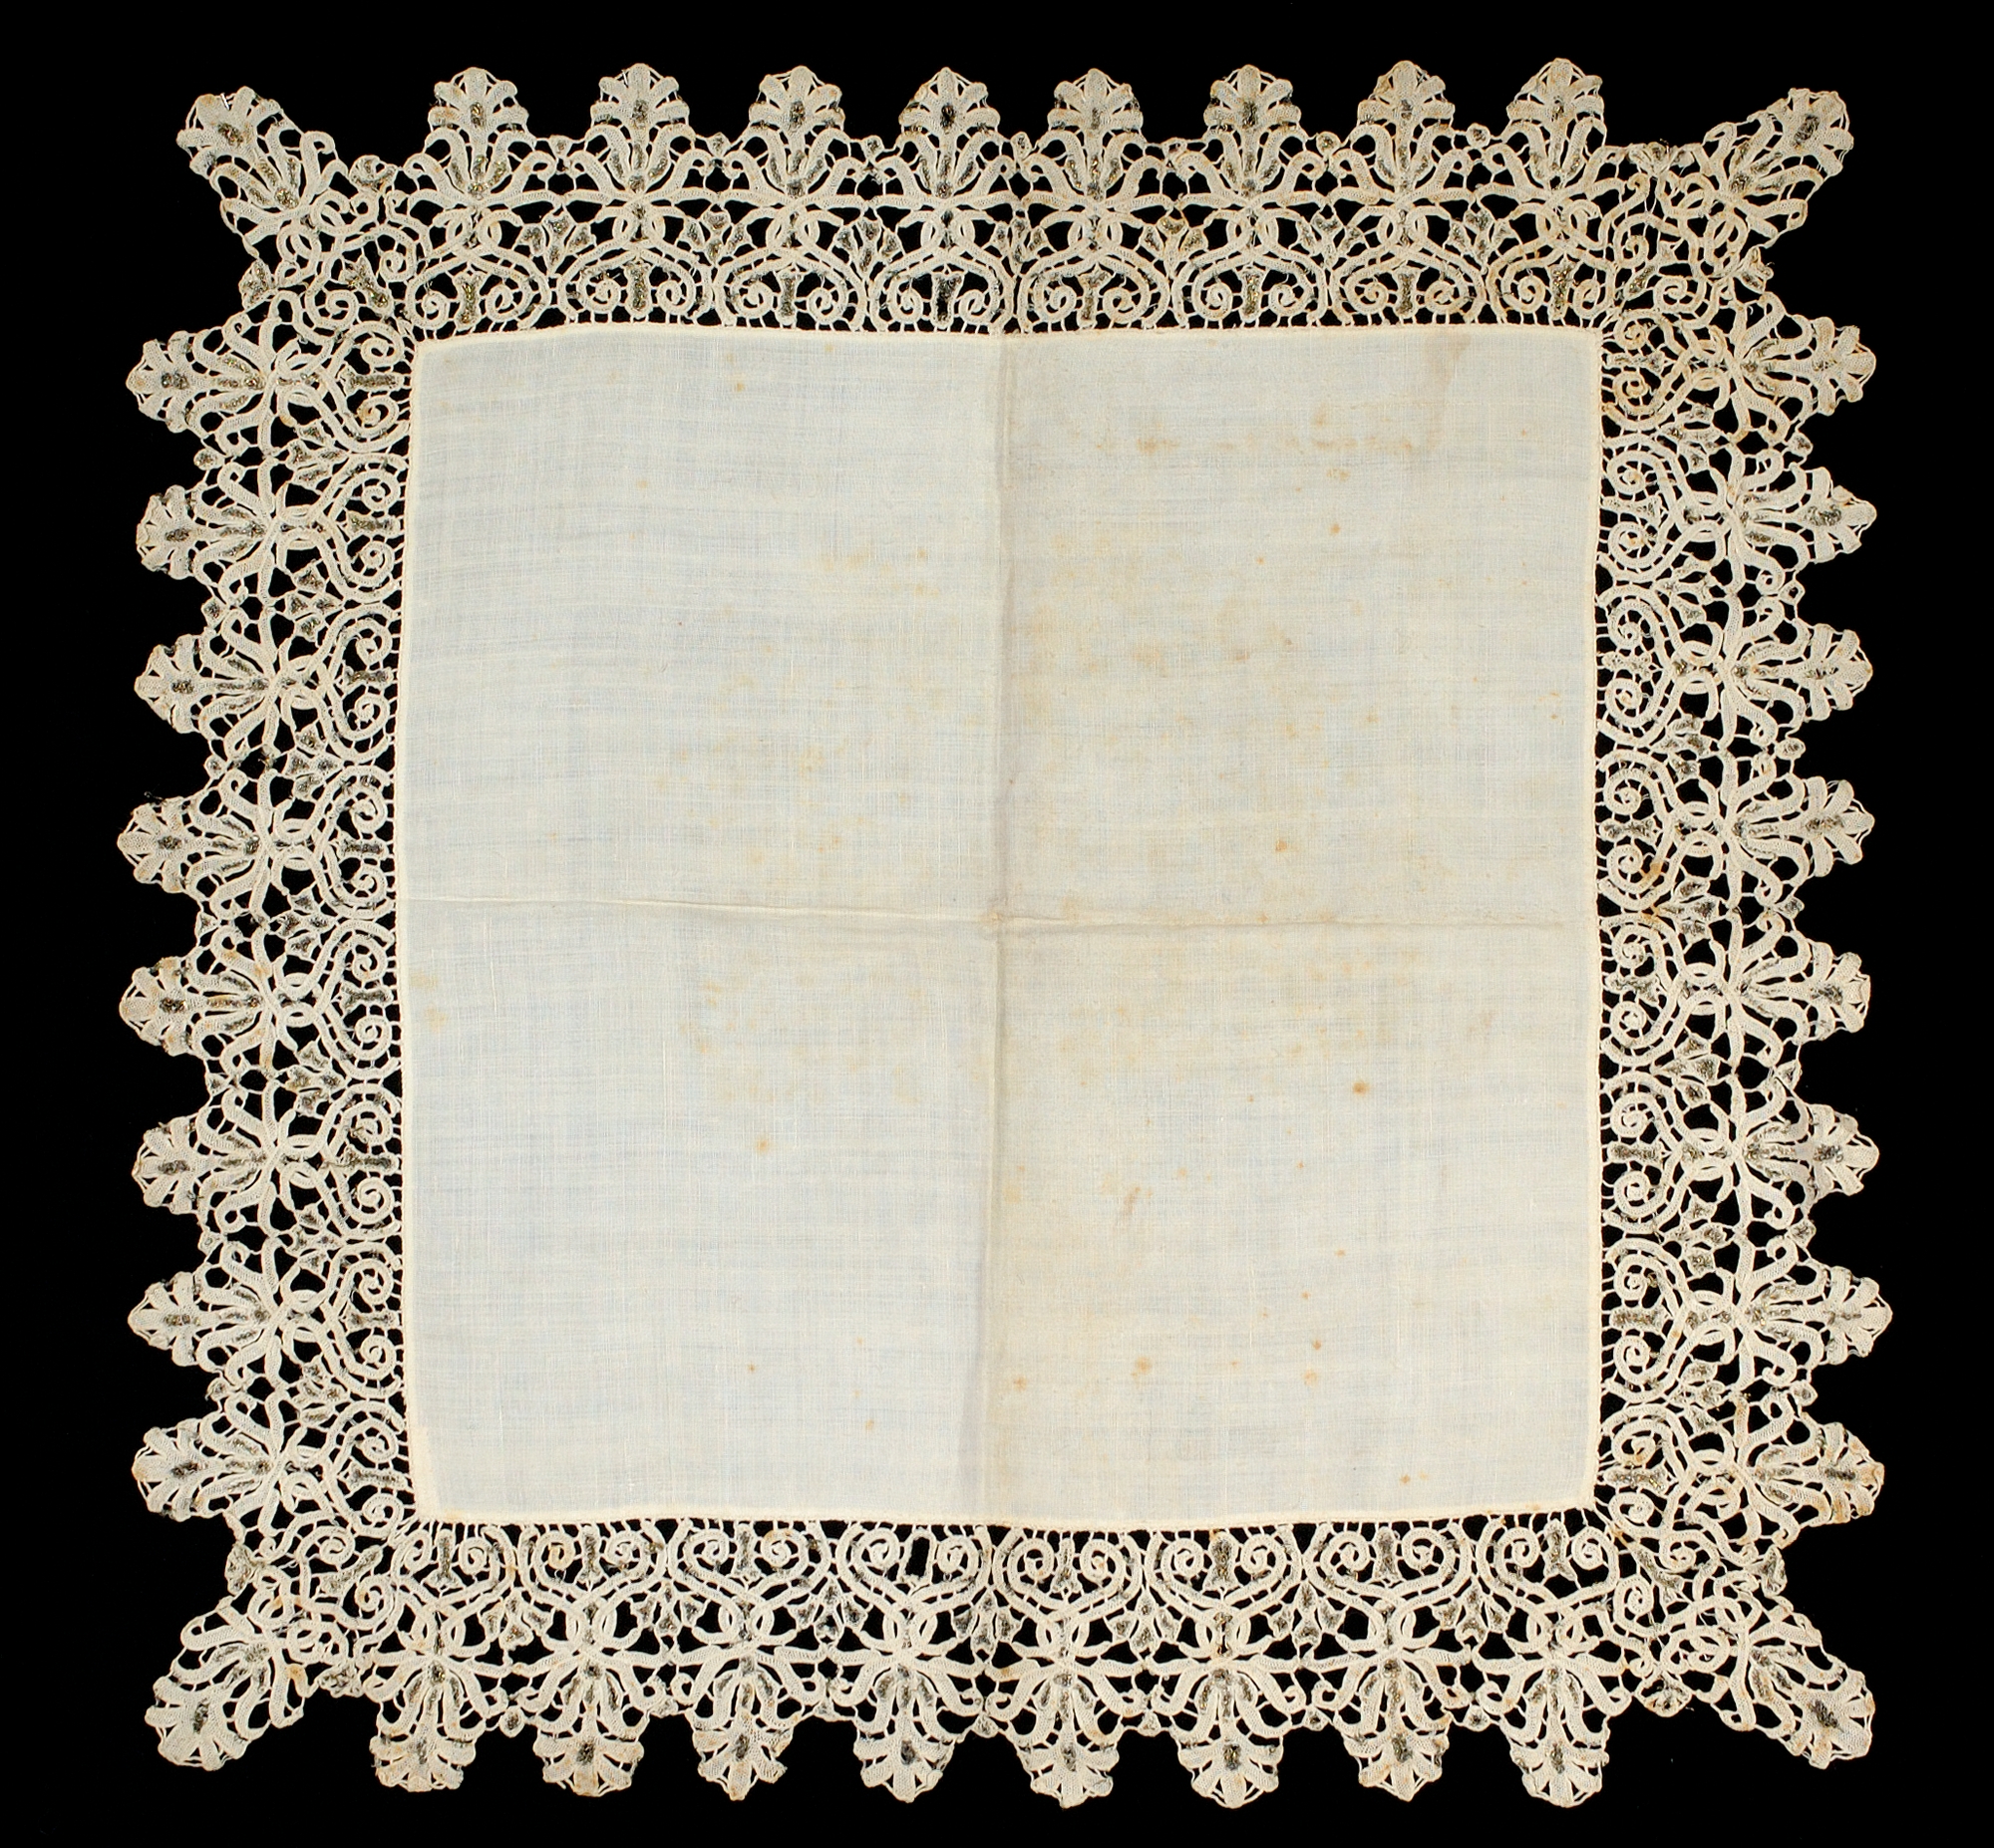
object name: handkerchief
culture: european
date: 1801-1900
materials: linen